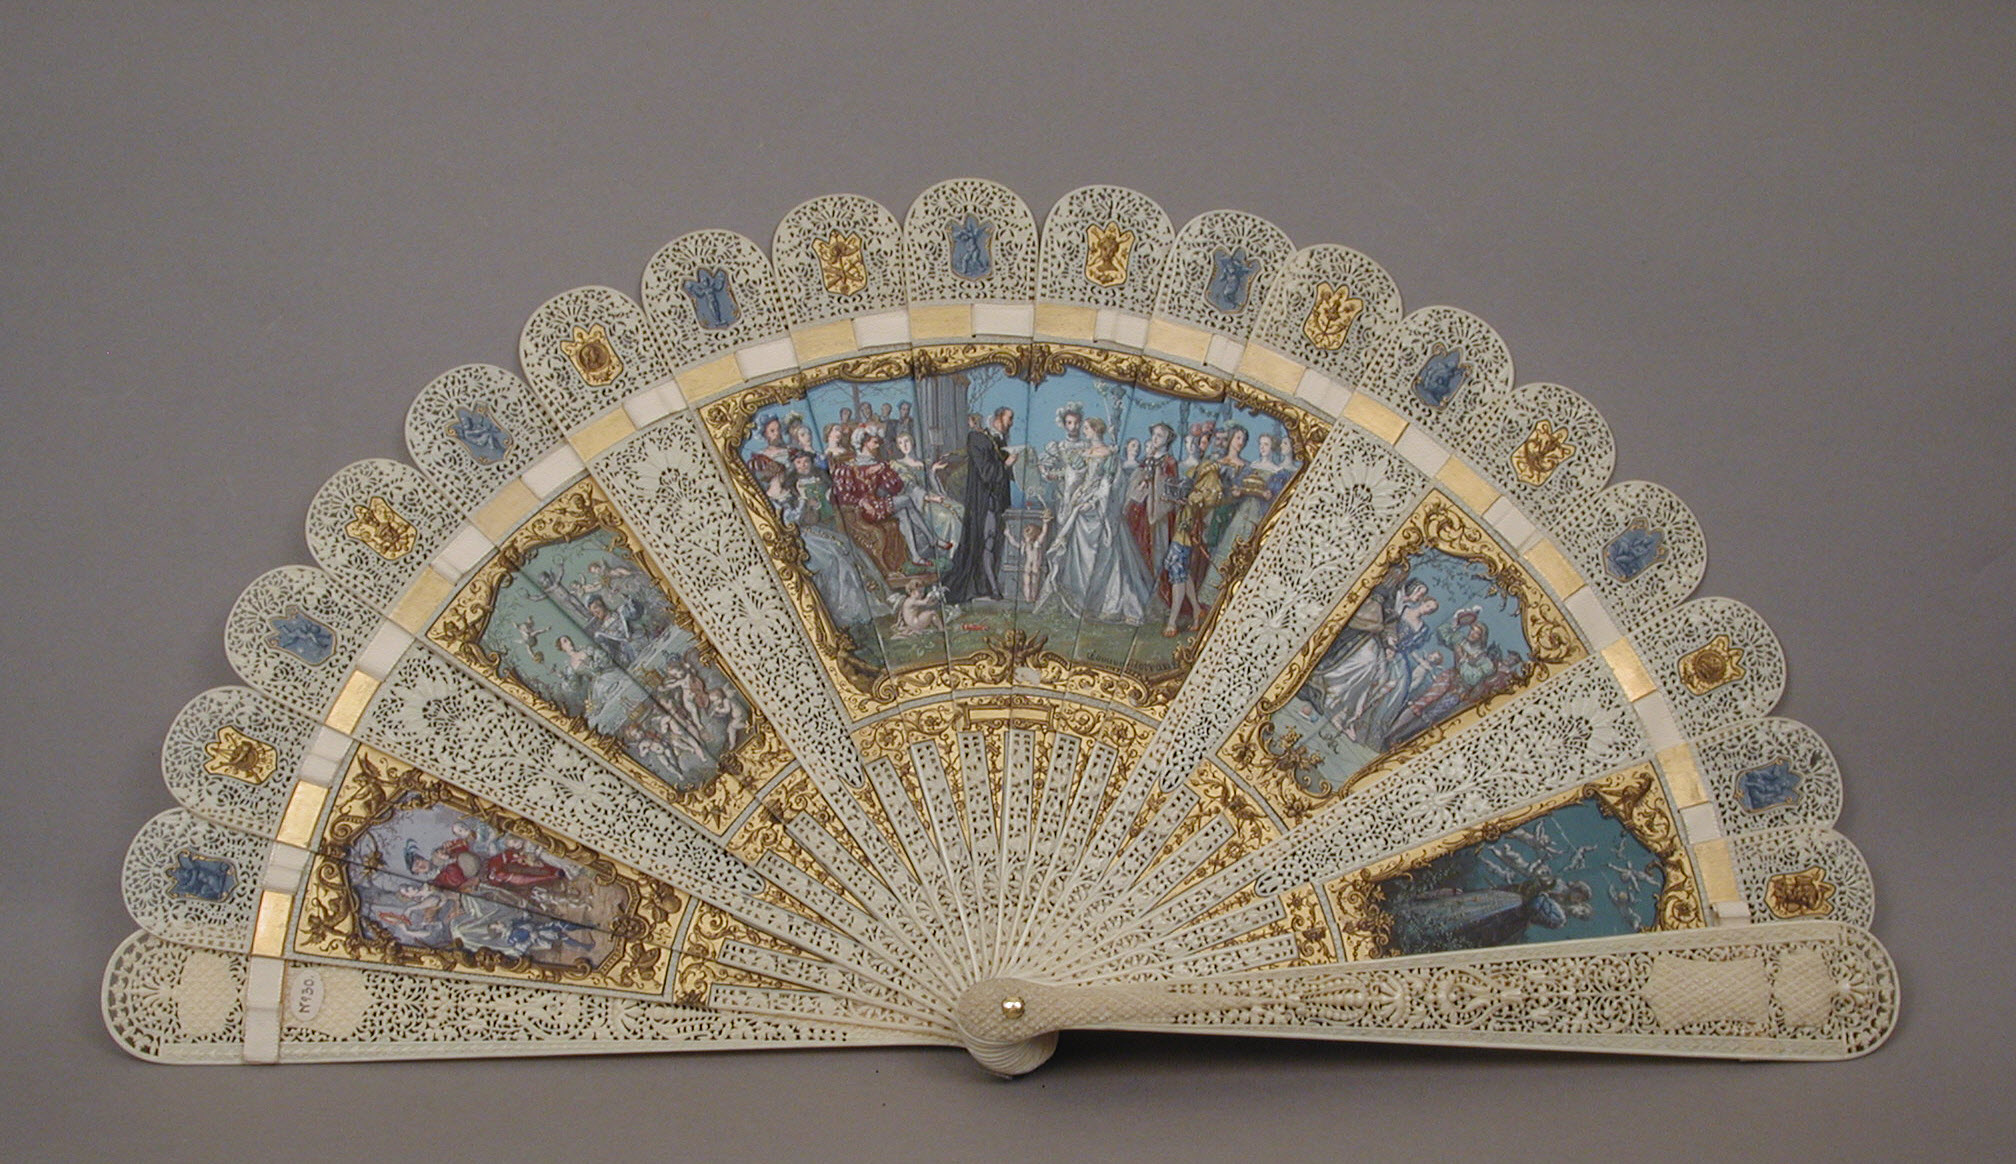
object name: fan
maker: edouard moreau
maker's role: maker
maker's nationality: french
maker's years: 1825-1878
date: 1860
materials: ivory, paint, ribbon, silk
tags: men,women,putti,weddings